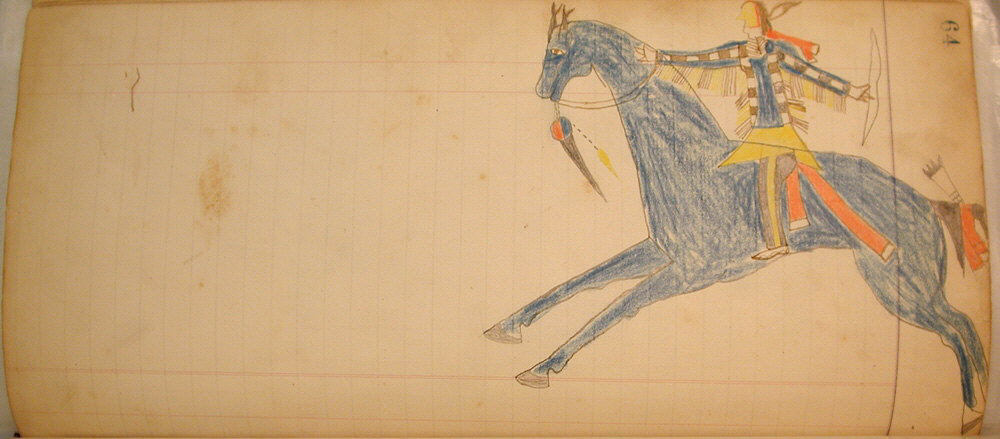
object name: drawing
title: Maffet Ledger: Drawing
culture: cheyenne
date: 1874-1881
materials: crayon, graphite, paper, watercolor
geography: united states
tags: men,horses